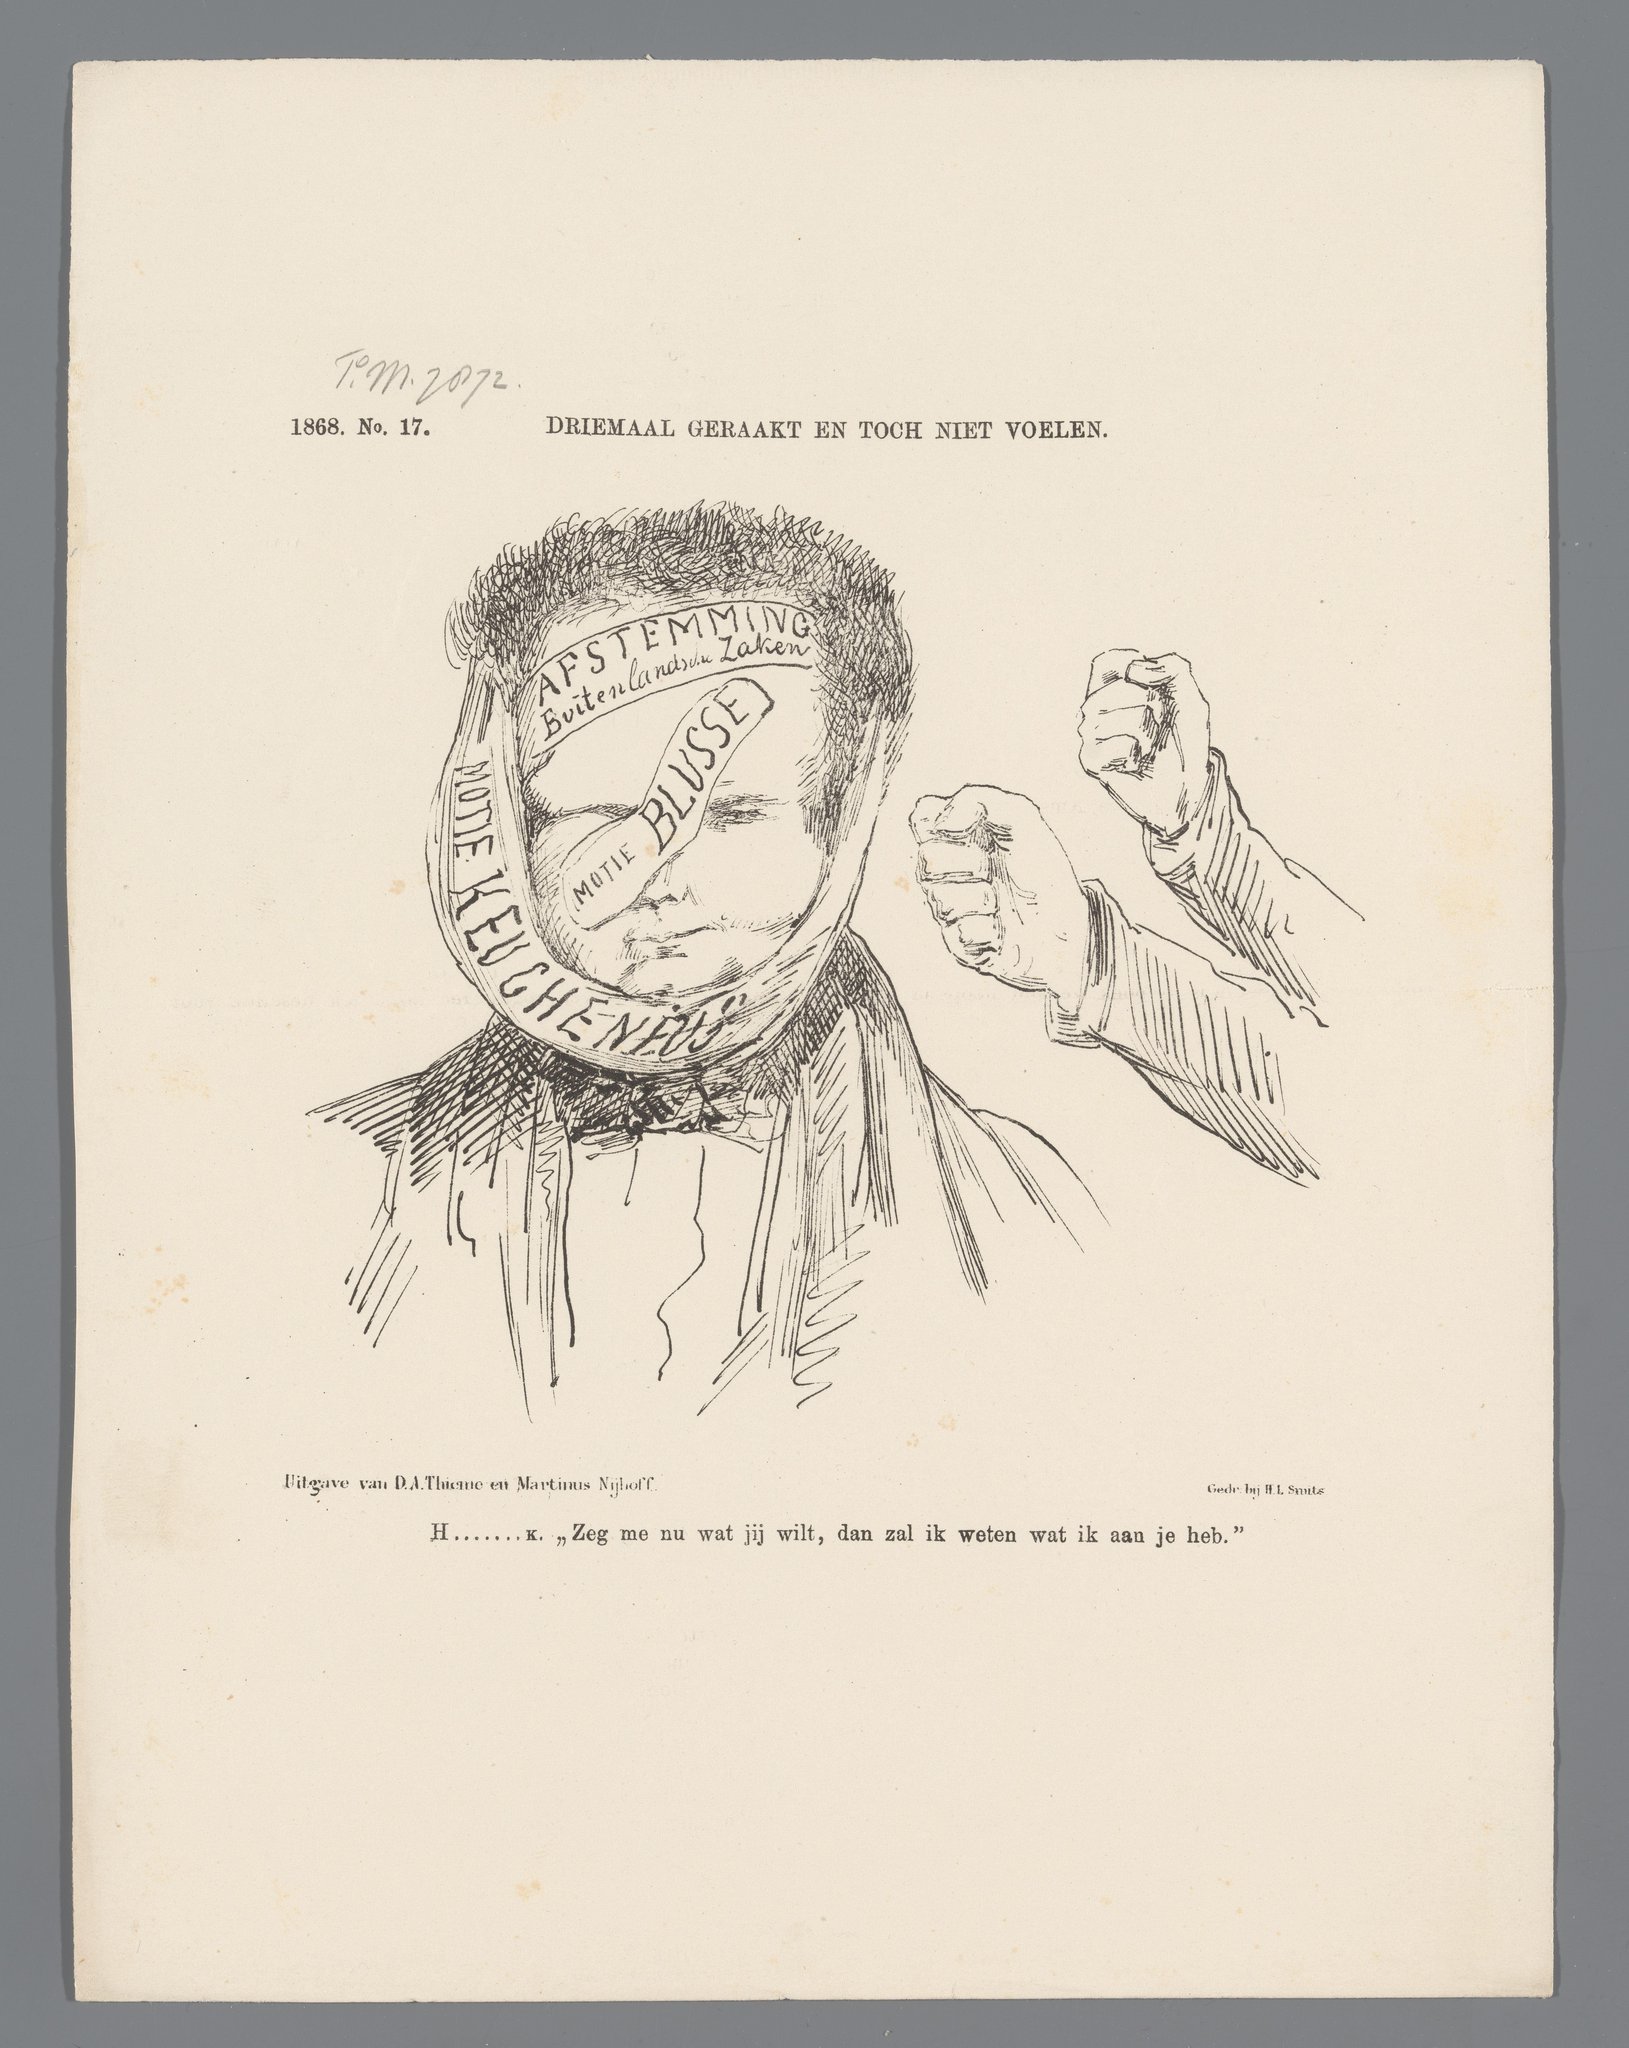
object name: print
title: Spotprent op minister Heemskerk, 1868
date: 1867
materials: paper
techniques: lithograph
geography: netherlands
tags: amsterdam, the hague, politician, dressing, bandage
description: Spotprent op ministerie Heemskerk wiens hoofd onder de verbanden zit. Plaat verschenen bij het weekblad De Nederlandsche Spectator, nr. 17, 25 april 1868.